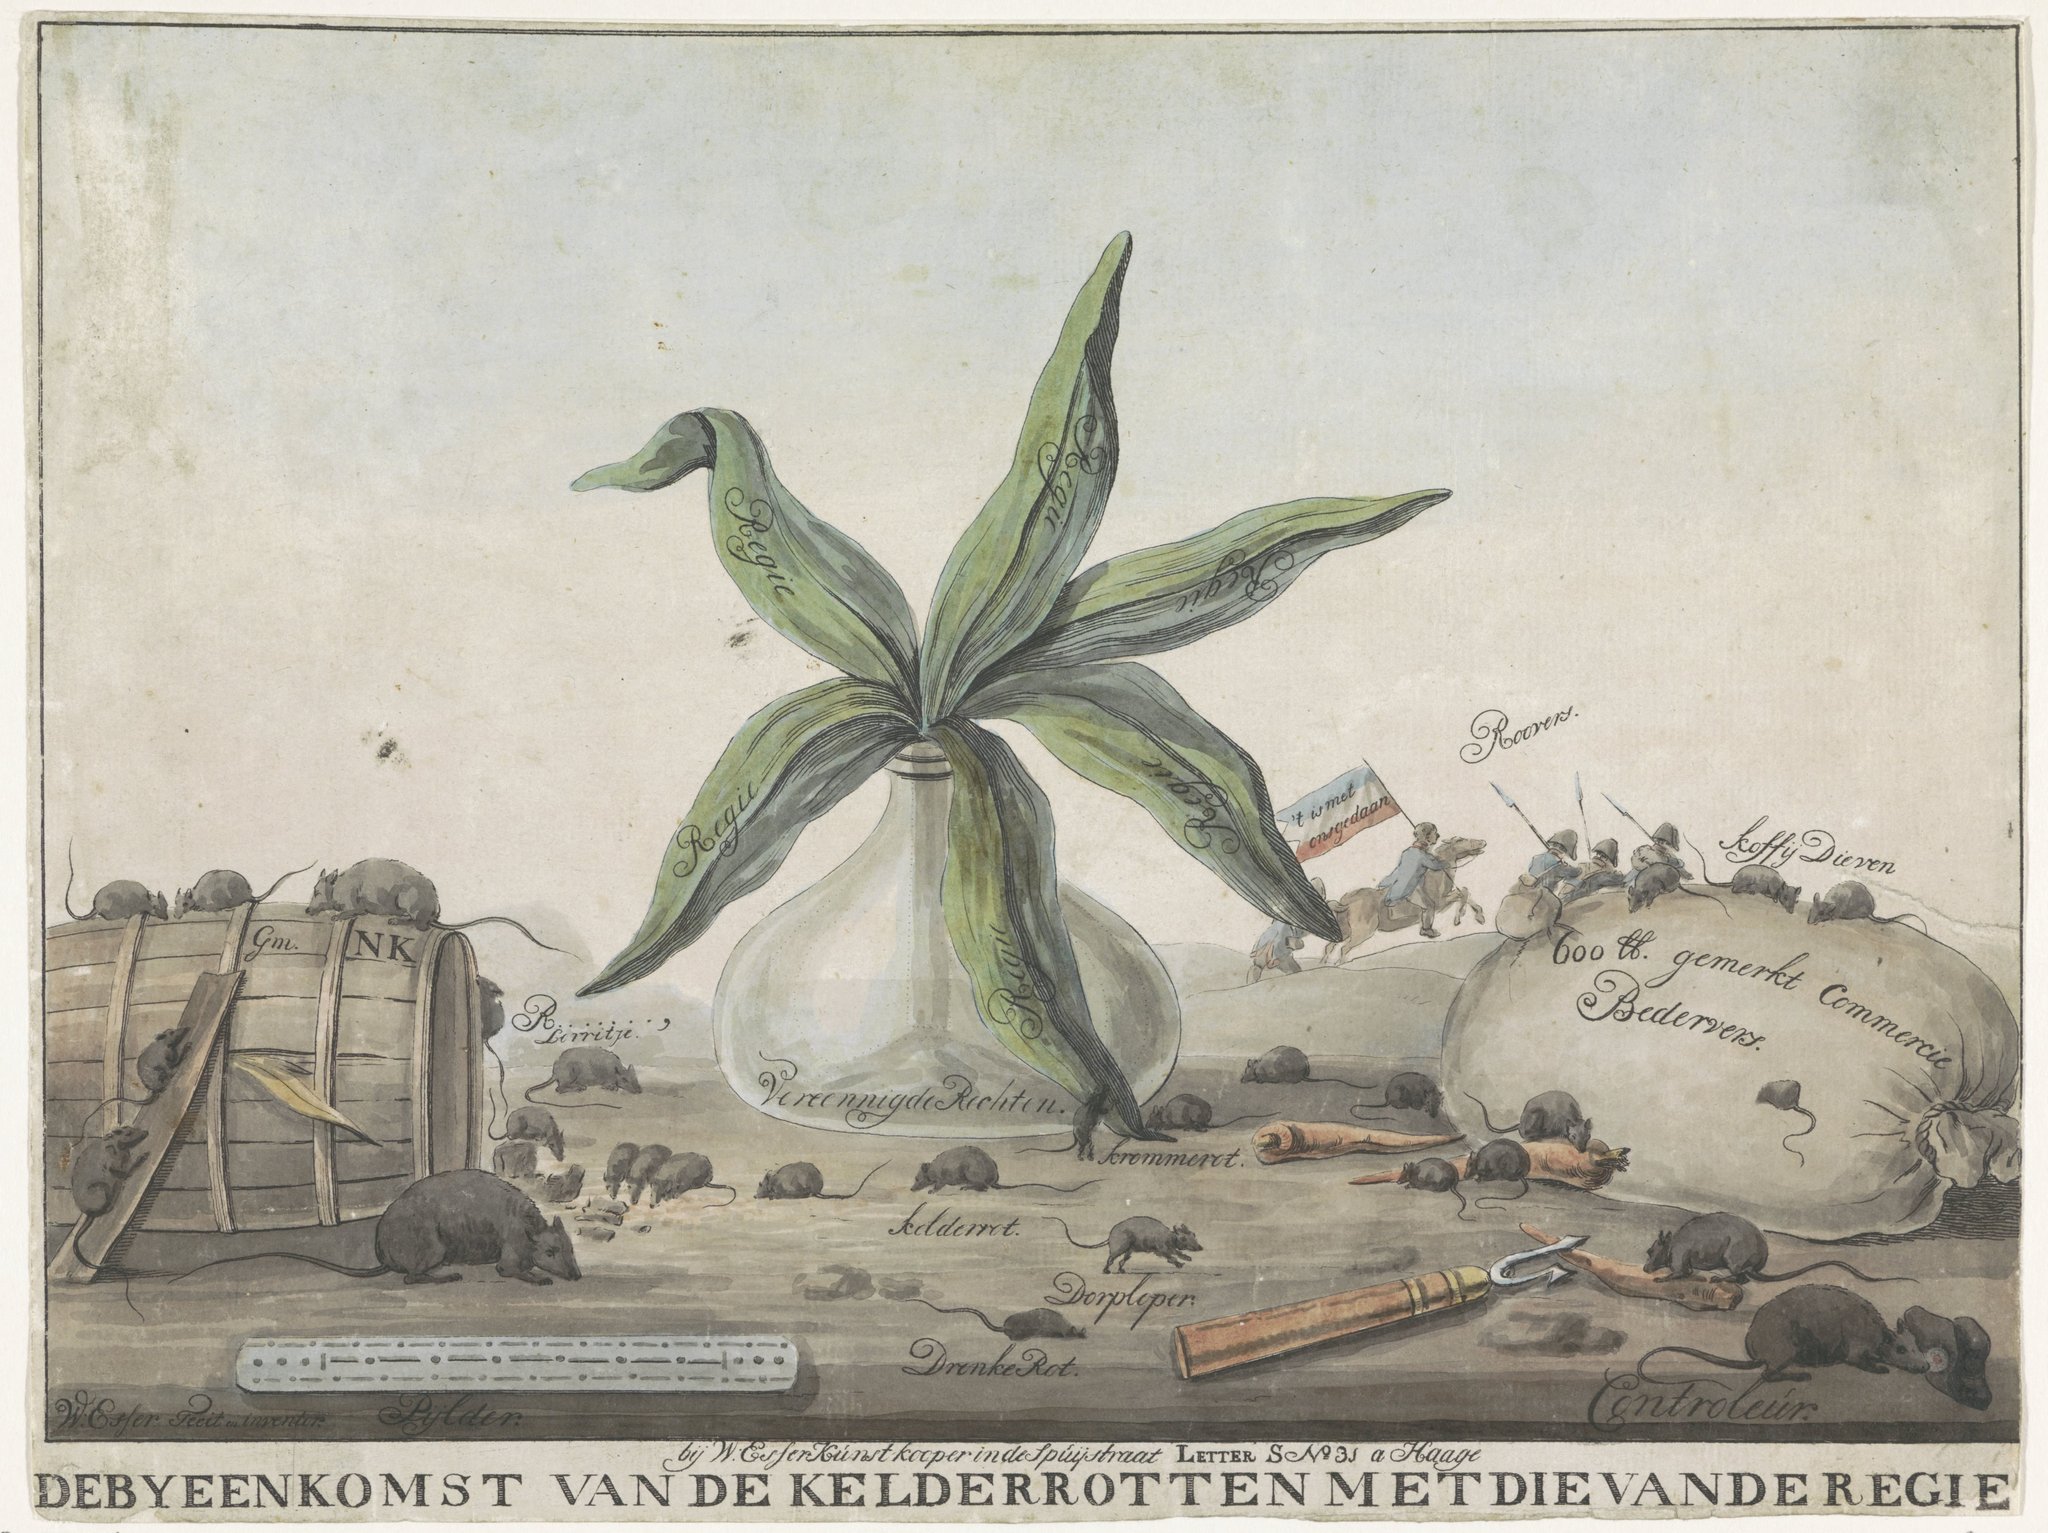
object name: cartoon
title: De Byeenkomst van de Kelderrotten met die van de Regie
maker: wijnand esser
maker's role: draughtsman, print maker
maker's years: 1779-1860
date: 1813-1814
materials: paper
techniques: etching, hand coloring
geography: the hague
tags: coffee, rodents: rat, customs, tobacco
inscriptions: collector's mark: Lugt 2228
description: Centraal een tabaksplant 'Regie' in een glazen fles gemerkt 'Vereenigde Rechten', links een vat tabak, rechts een zak koffiebonen. Ratten met namen als 'kelderrot', 'controleur' en Dronke Rot' kruipen over alles heen. Op de achtergrond vluchten de Franse douanen uit Nederland.